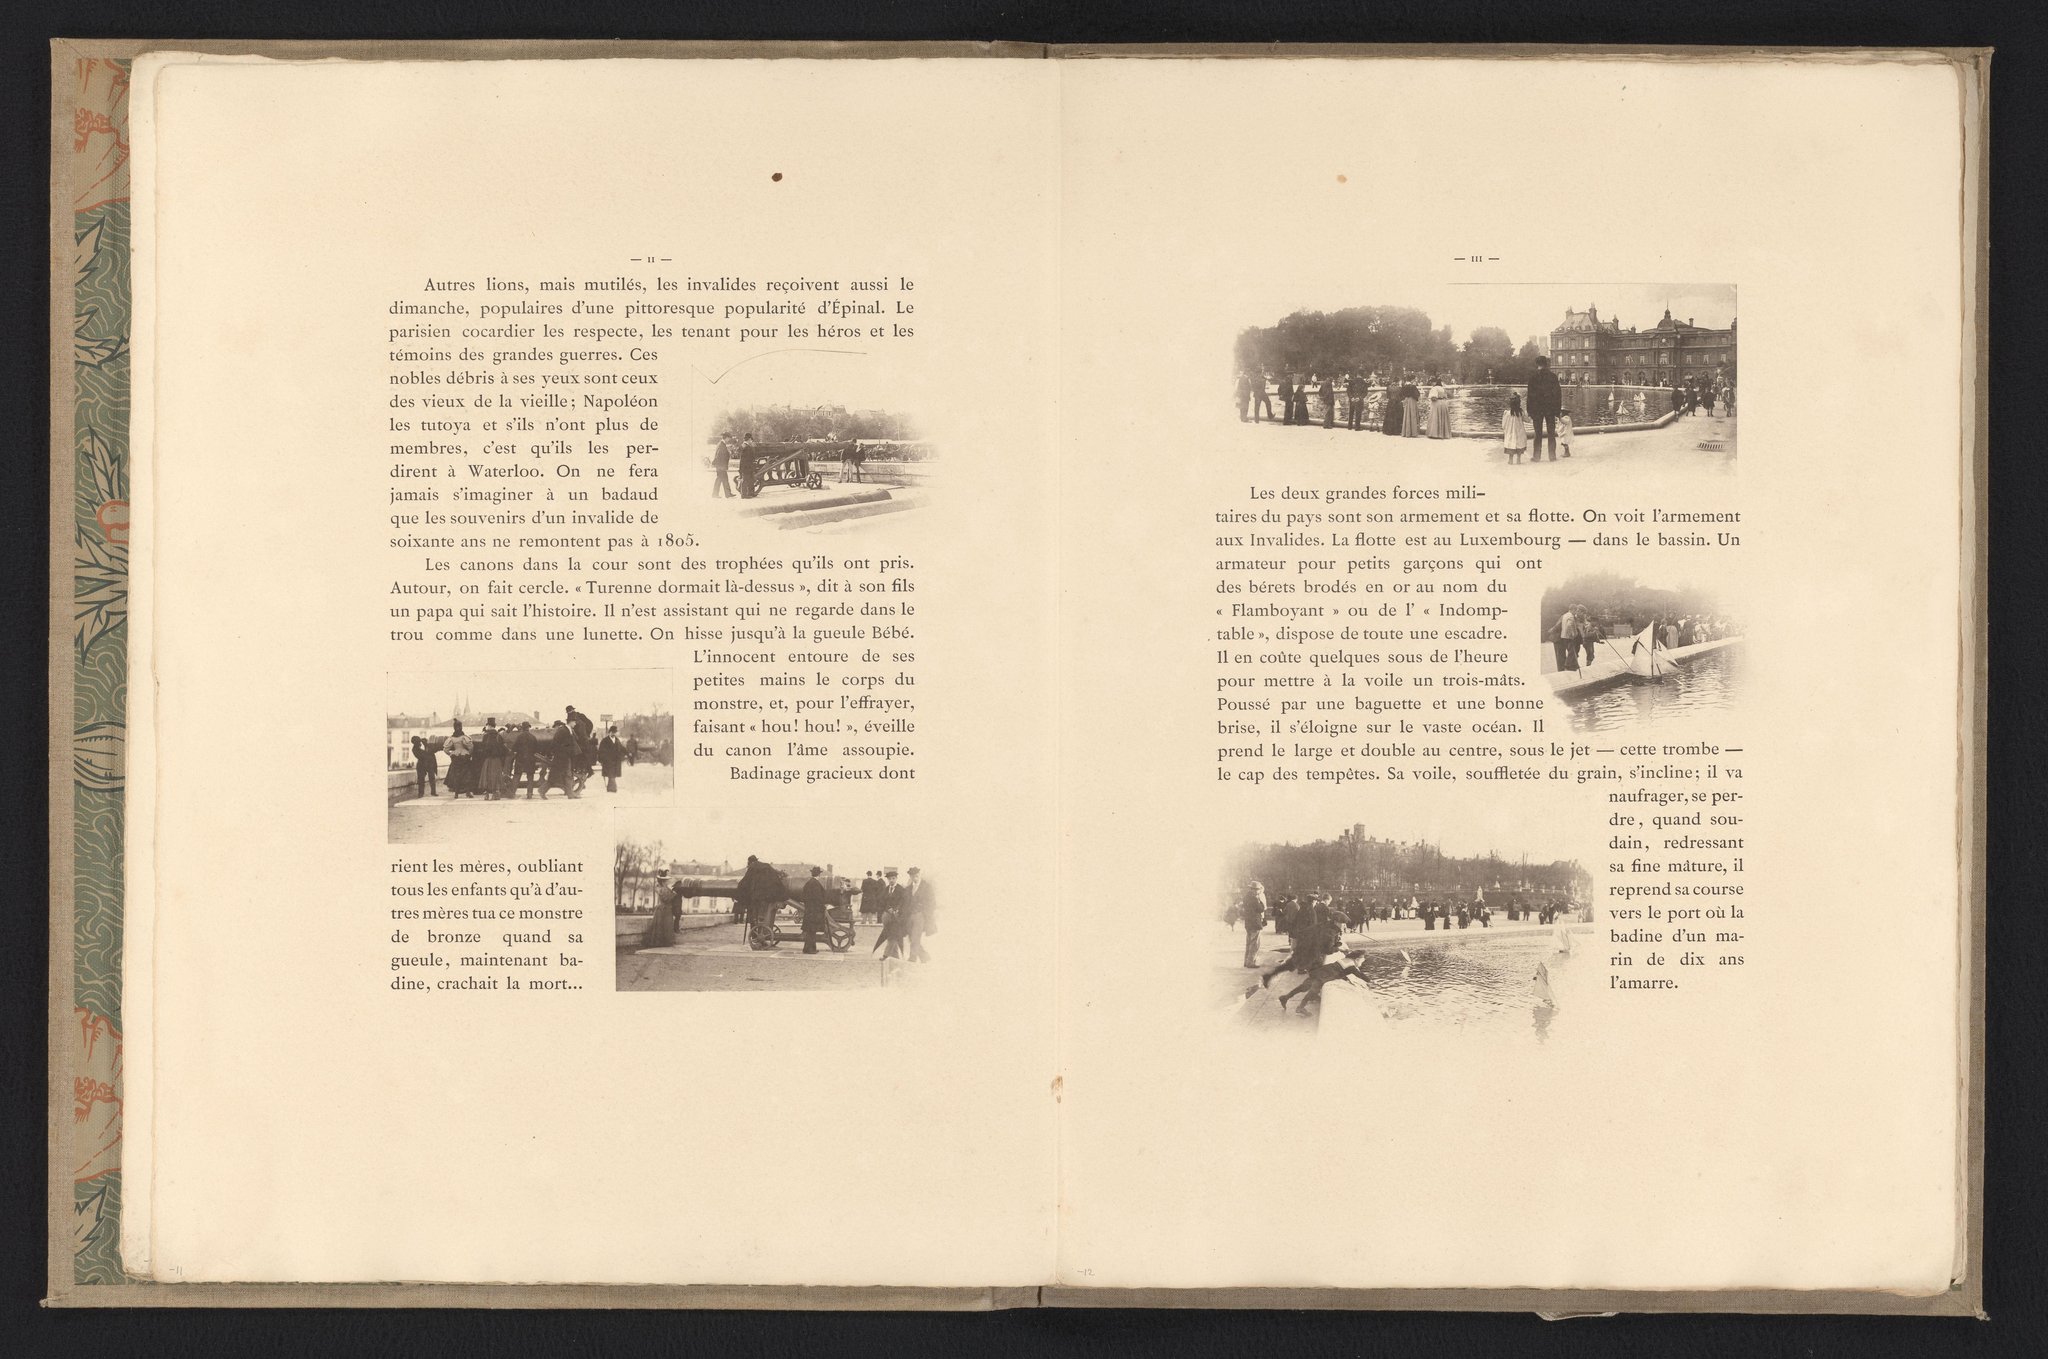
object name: photomechanical print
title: Drie taferelen met Parijzenaren bij de vijver in het Jardin du Luxembourg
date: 1896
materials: paper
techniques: photograph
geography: châteaudun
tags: garden pond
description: Prenten op zeventiende ongenummerde pagina.